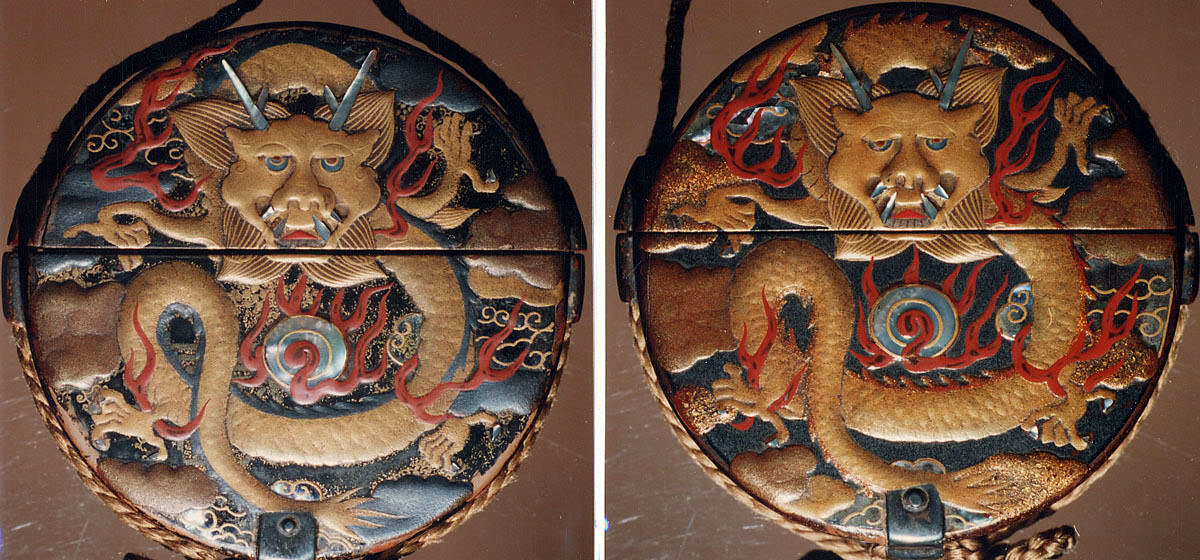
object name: inrō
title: Case (Inrō) with Design of Flaming Dragon with Clouds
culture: japanese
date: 1834-1866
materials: gold, lacquer, metal, silver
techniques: hiramakie, roiro, maki-e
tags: dragons